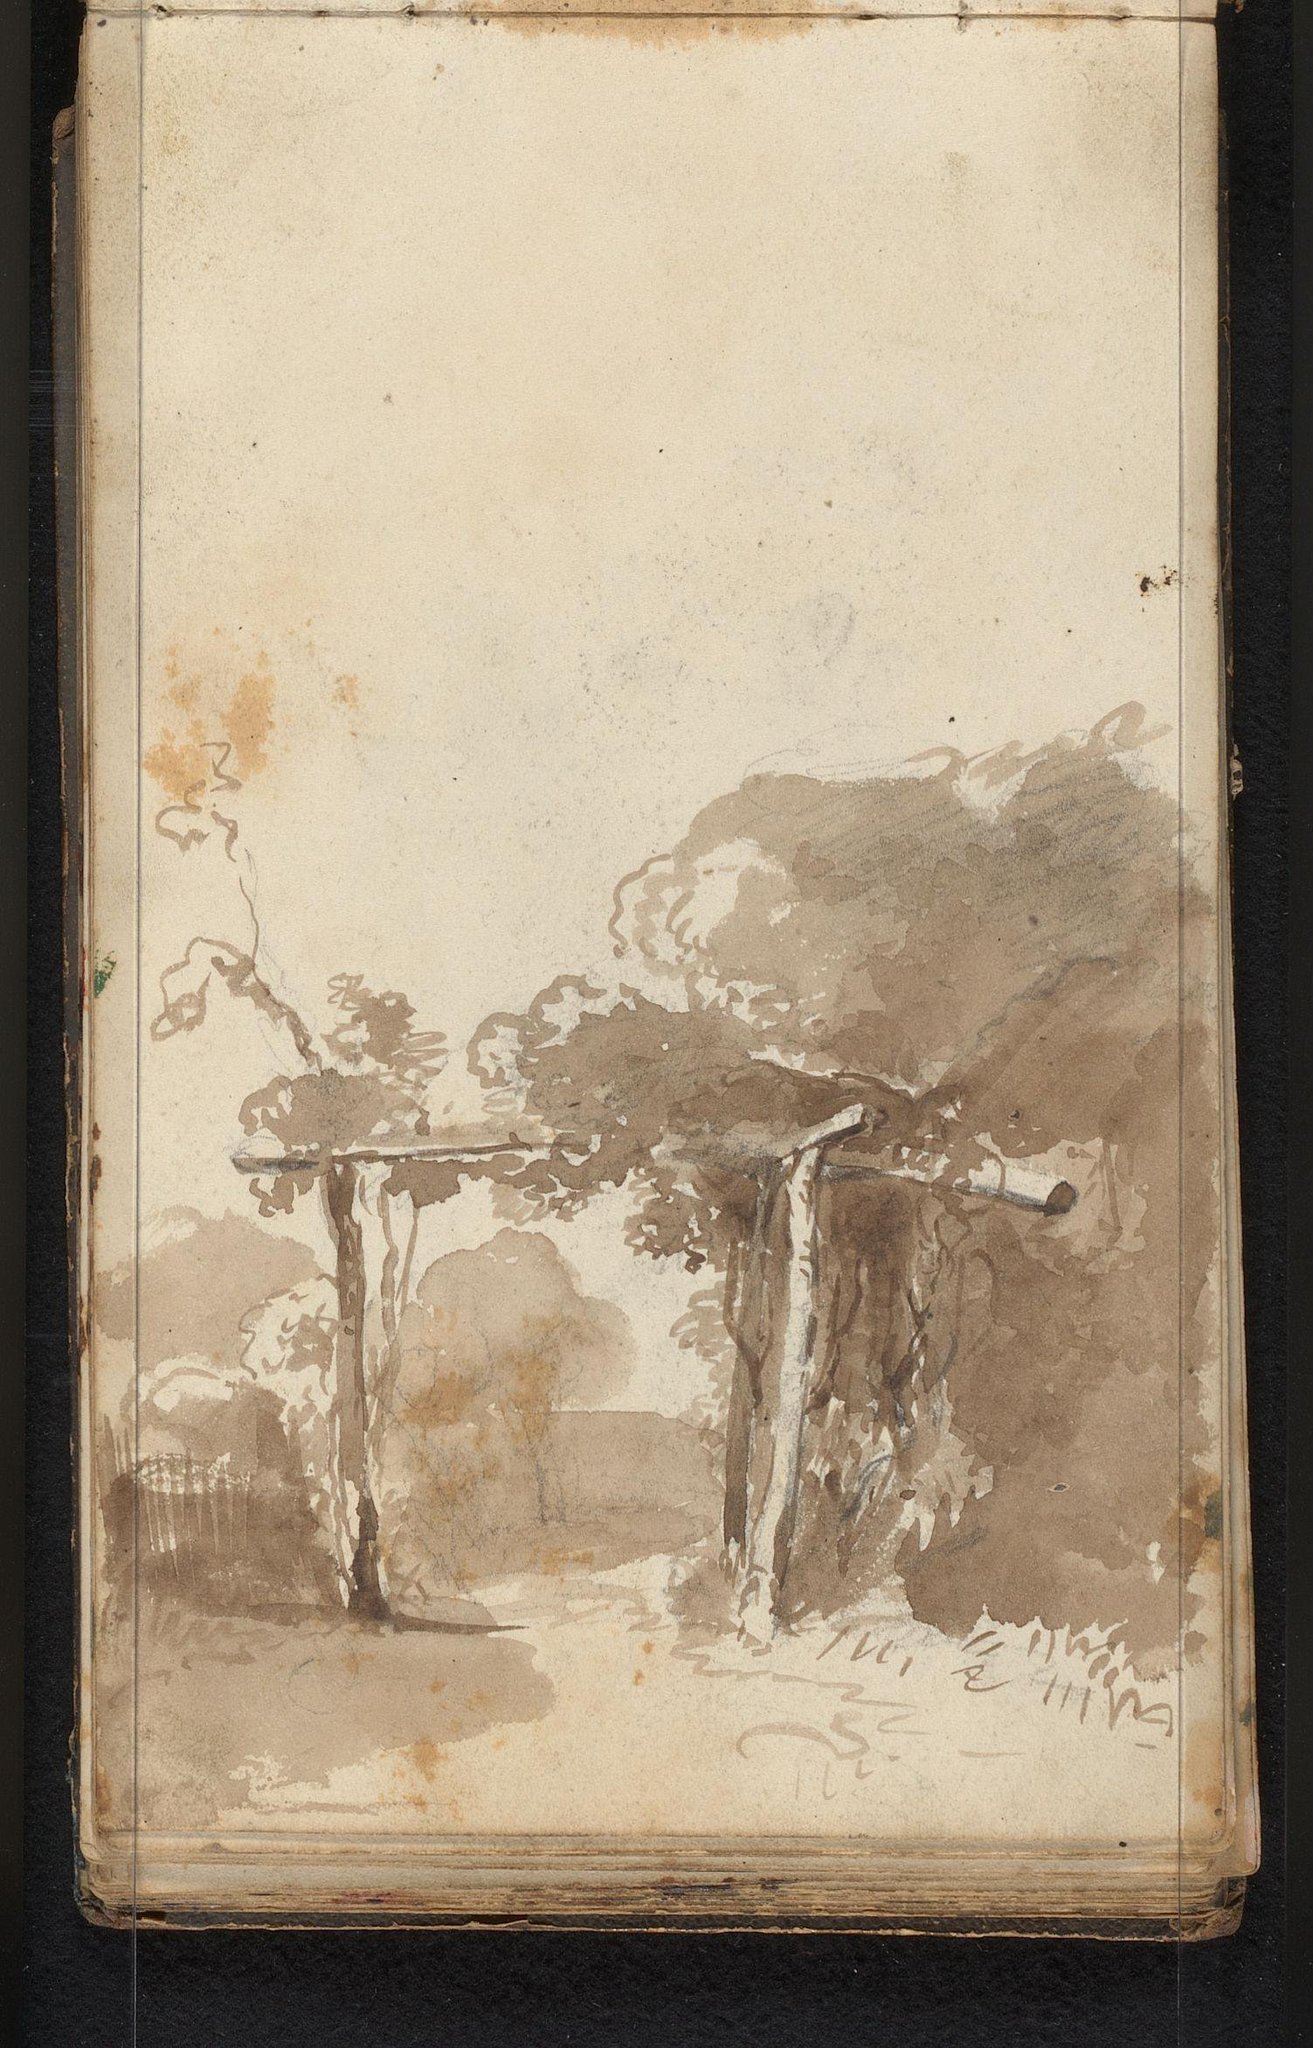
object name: sketchbook leaf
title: Landschap met poort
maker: jan bedijs tom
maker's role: draughtsman, painter, print maker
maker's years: 1813-1894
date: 1828-1894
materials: paper, pencil, watercolor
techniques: brush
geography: the hague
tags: plants; vegetation, landscapes, gate, entrance, artist (in general) making preliminary designs, sketching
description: Pagina 33 verso uit een schetsboek met 54 bladen.